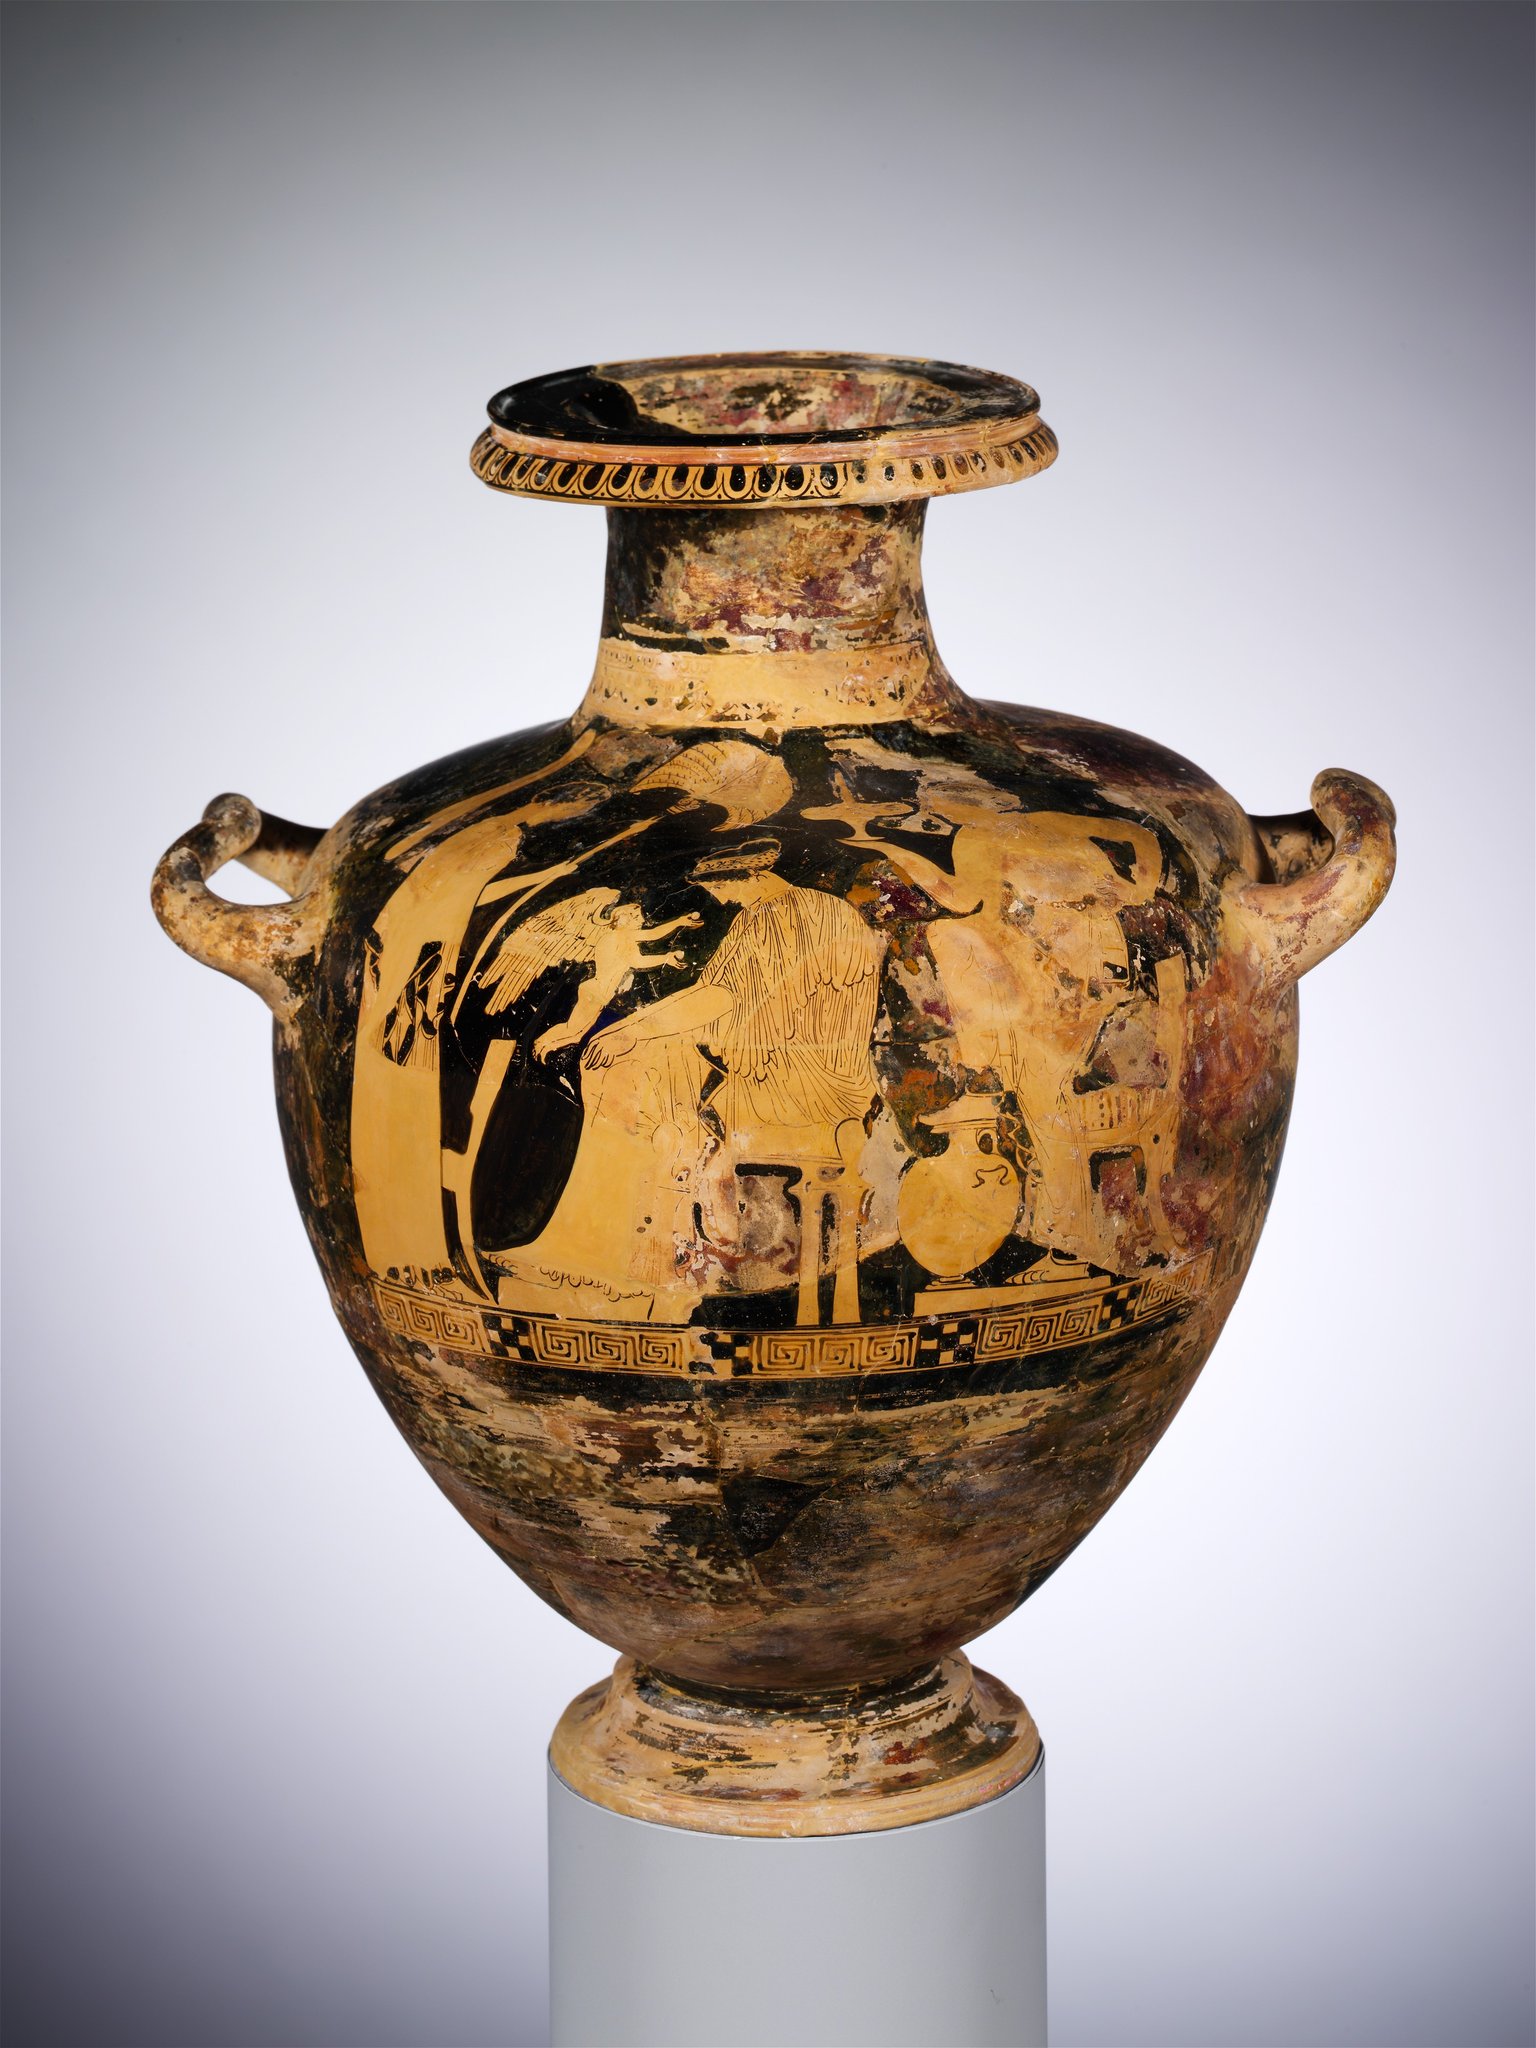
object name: hydria, kalpis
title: Terracotta hydria: kalpis (water jar)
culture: greek, attic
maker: washing painter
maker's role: artist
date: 430-420 BCE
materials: terracotta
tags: fans,women,eros